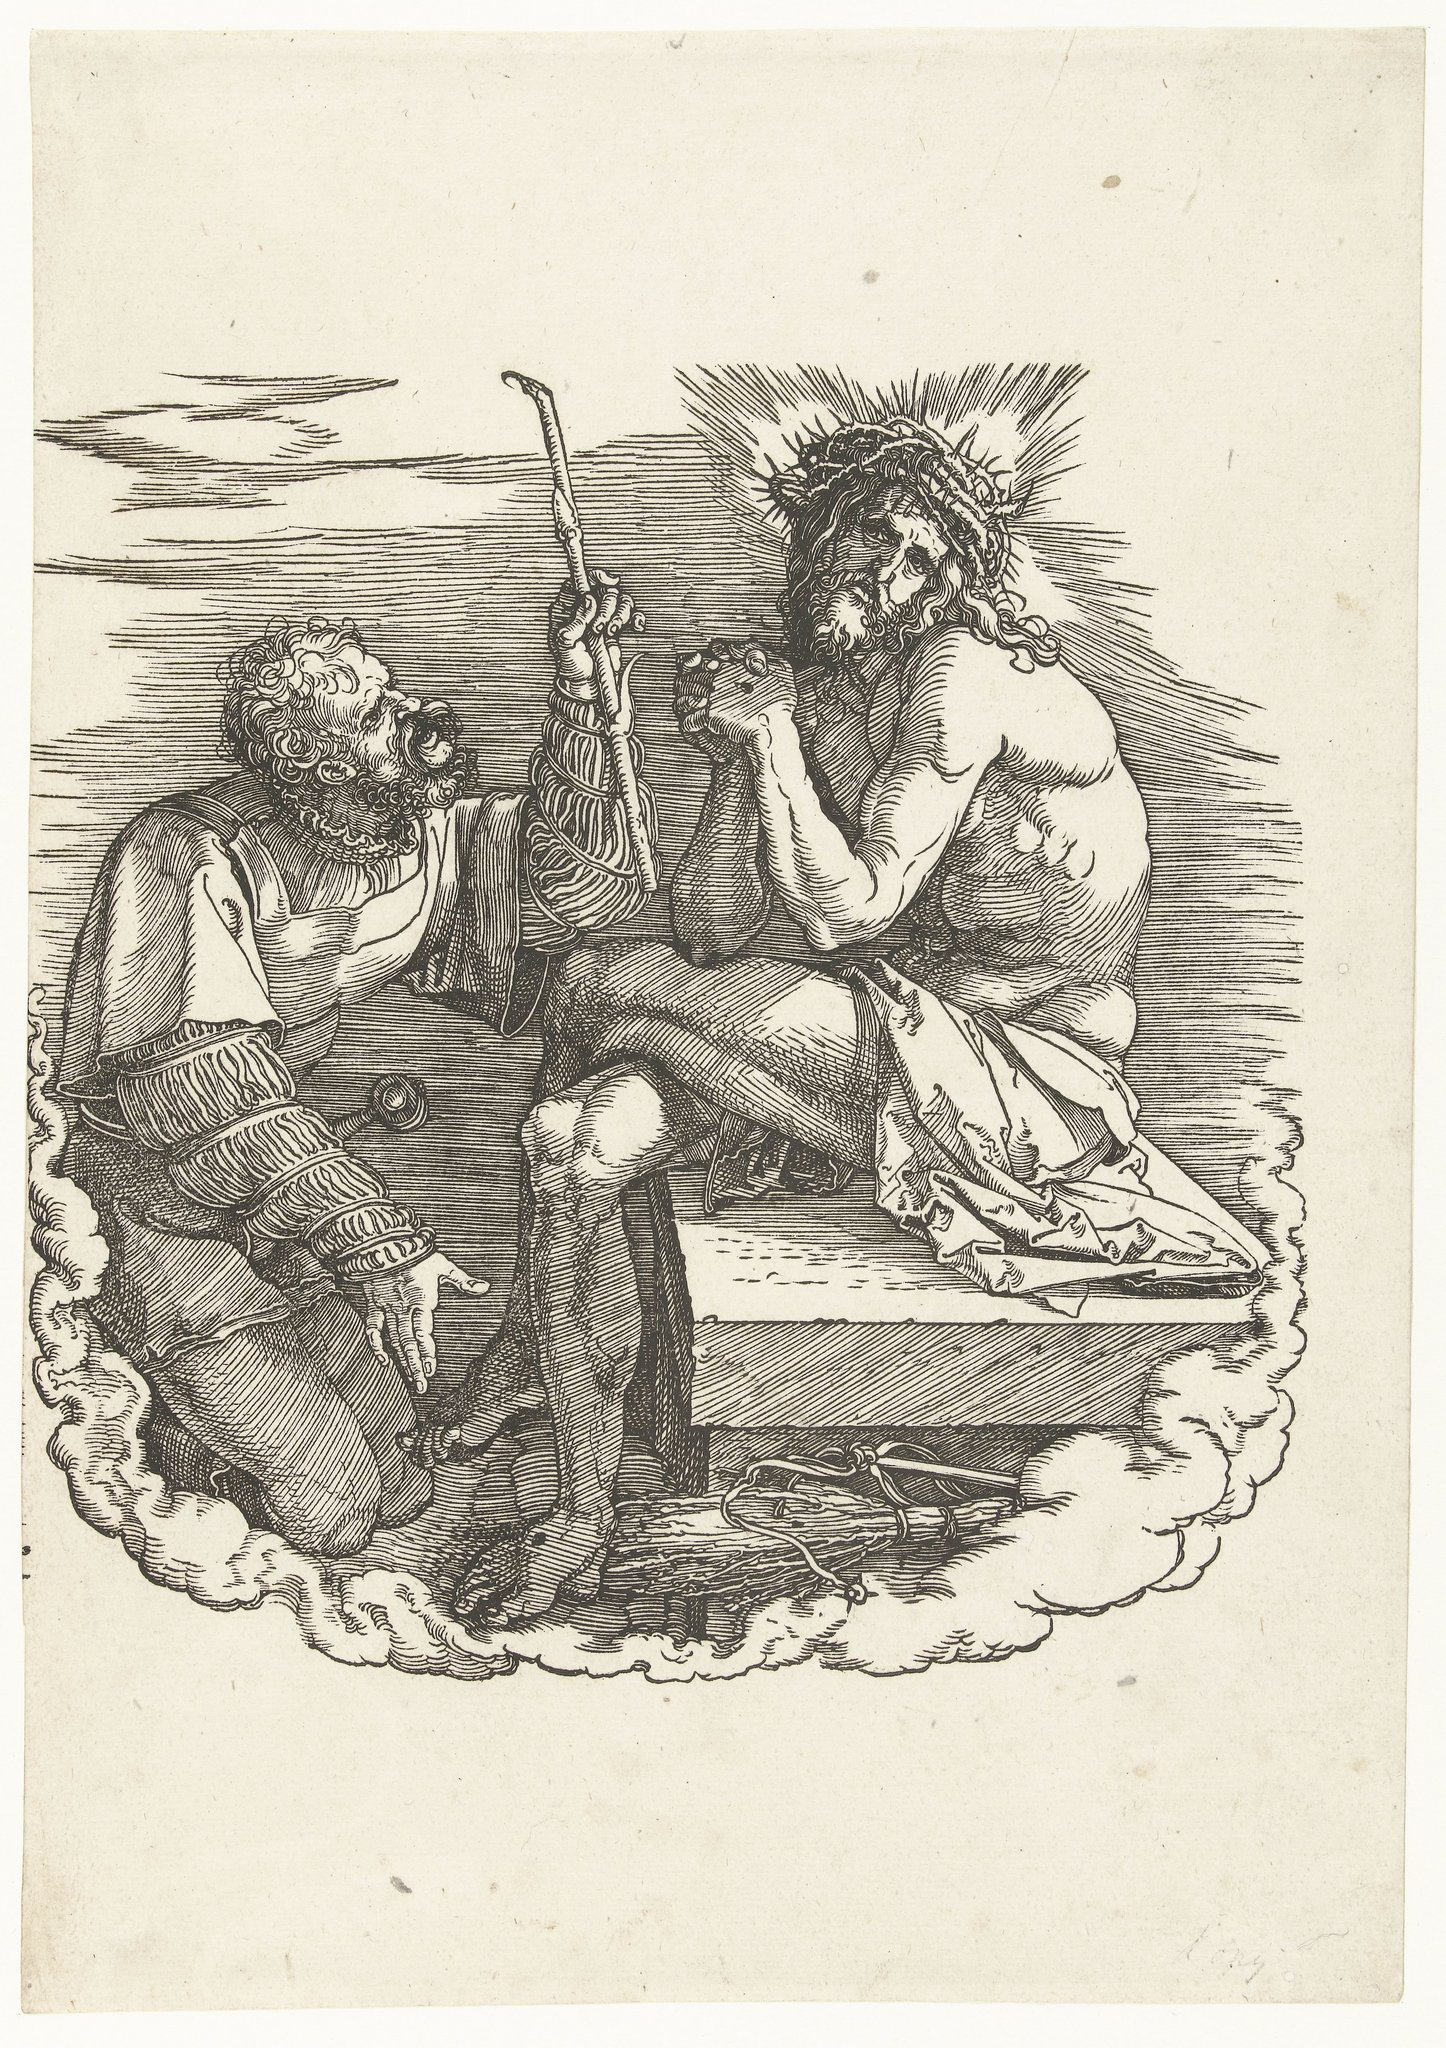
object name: print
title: Christus als Man van Smarten, bespot door een soldaat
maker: albrecht dürer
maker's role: draughtsman, painter, print maker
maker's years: 1471-1528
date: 1511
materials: paper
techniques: woodcut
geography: nuremberg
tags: man of sorrows, 'imago pietatis', 'erbärmdebild', 'schmerzensmann'; the upright christ showing his wounds, usually bearing the crown of thorns, and accompanied by the instruments of the passion, standing or sitting in his tomb, mockings of christ, who may be blindfolded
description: Christus zit op een blok steen, de doornenkroon op het hoofd. Een soldaat knielt voor hem en wil hem een tak als scepter in de handen duwen. Deze prent is de titelprent voor de prentserie 'De grote Passie', bestaande uit deze titelprent en 11 scènes uit het Lijdensverhaal.